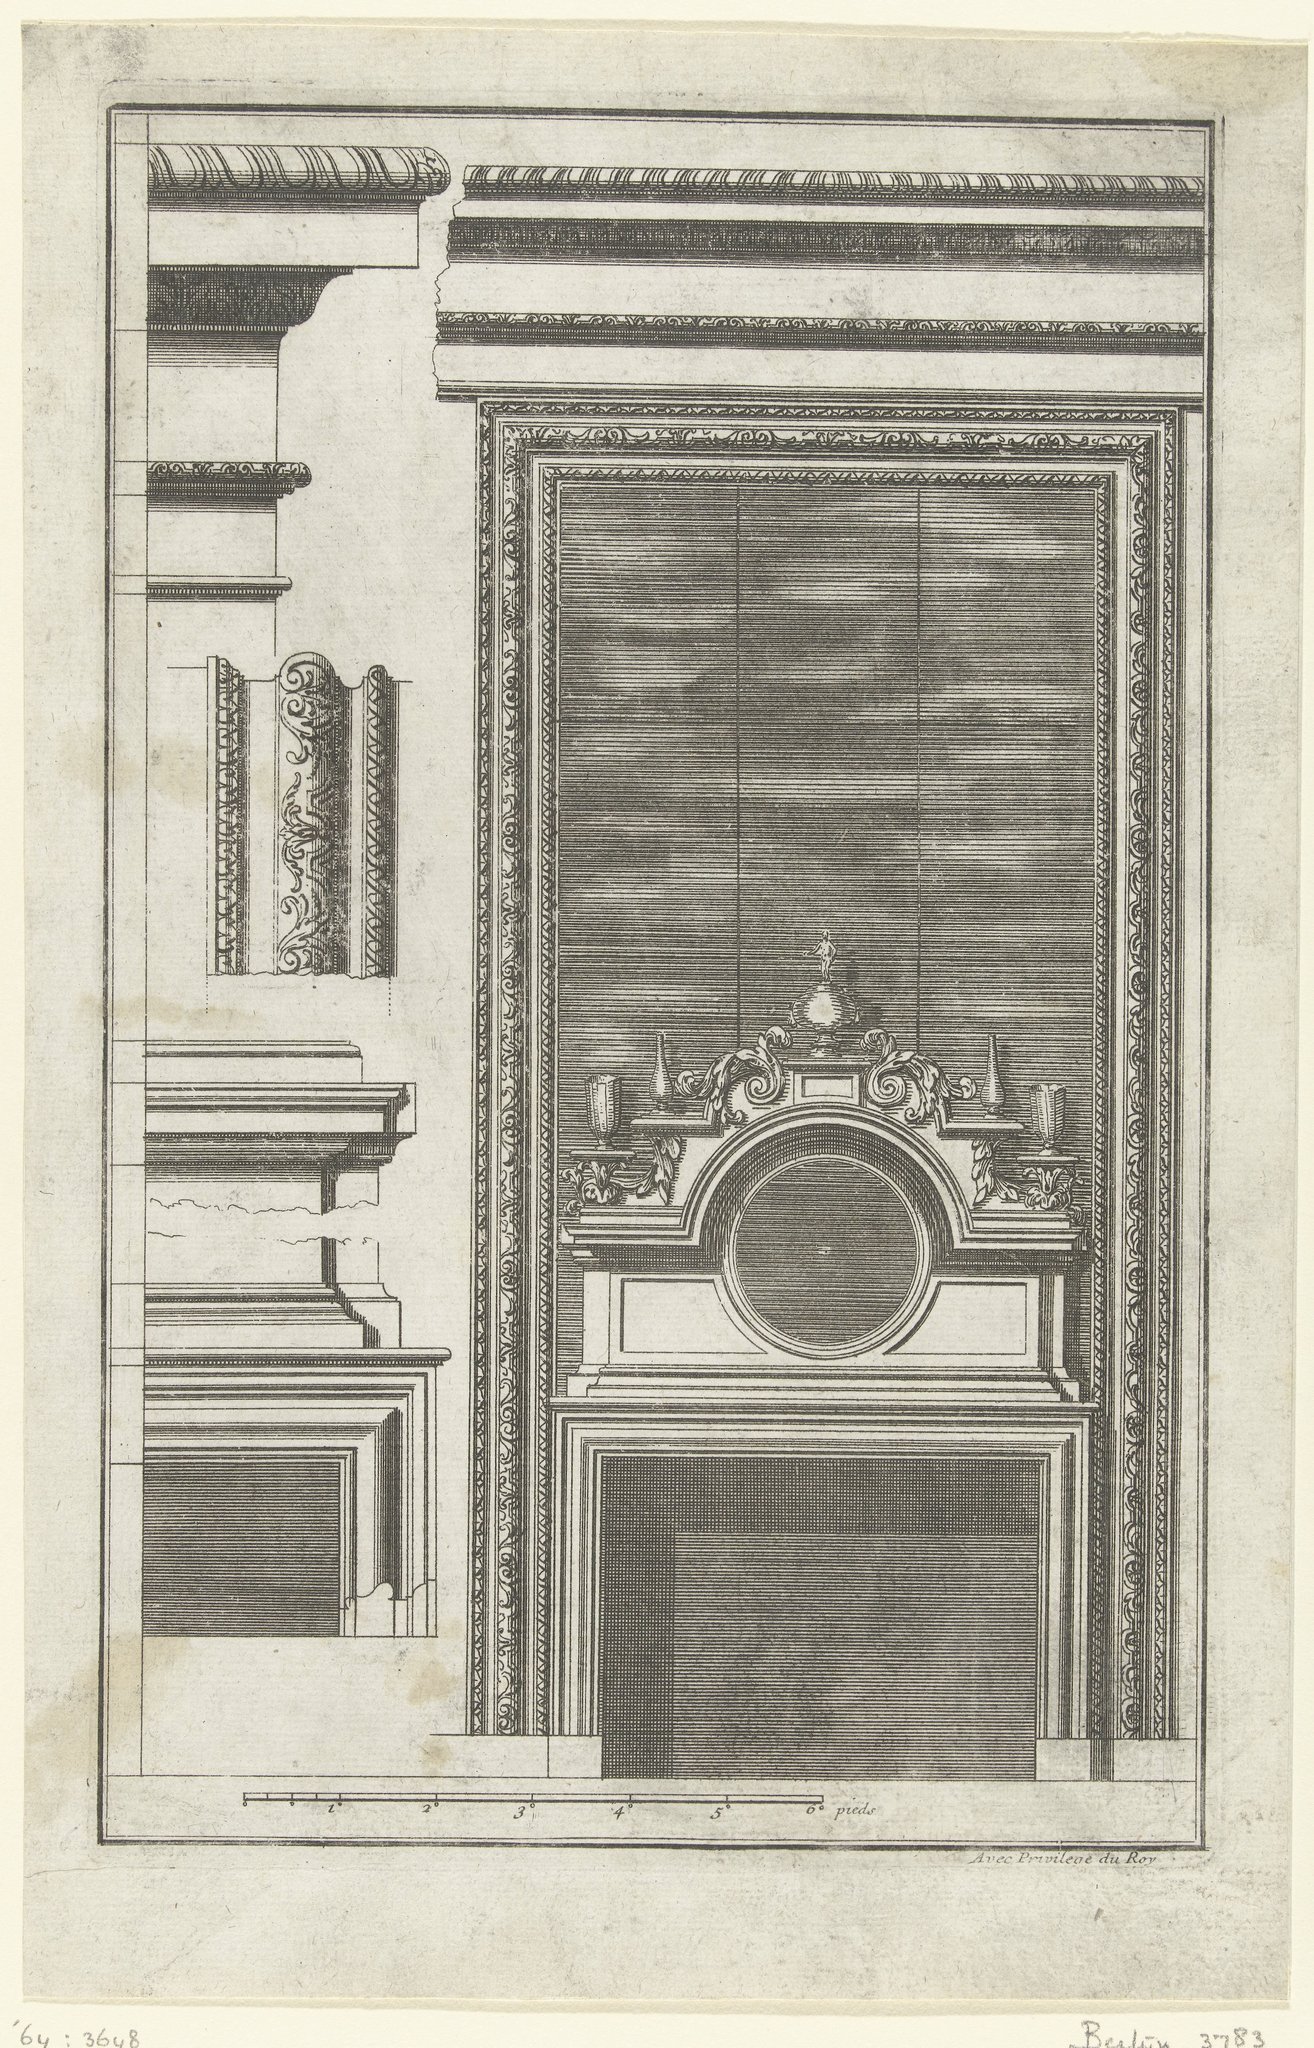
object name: print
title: Onderboezem omringd door lijstwerk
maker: françois de poilly (i)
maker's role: print maker, publisher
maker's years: 1622-1693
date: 1632-1693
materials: paper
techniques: etching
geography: paris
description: Links zijn verschillende details afgebeeld. Uit serie van titelblad en 5 bladen, tweede editie.